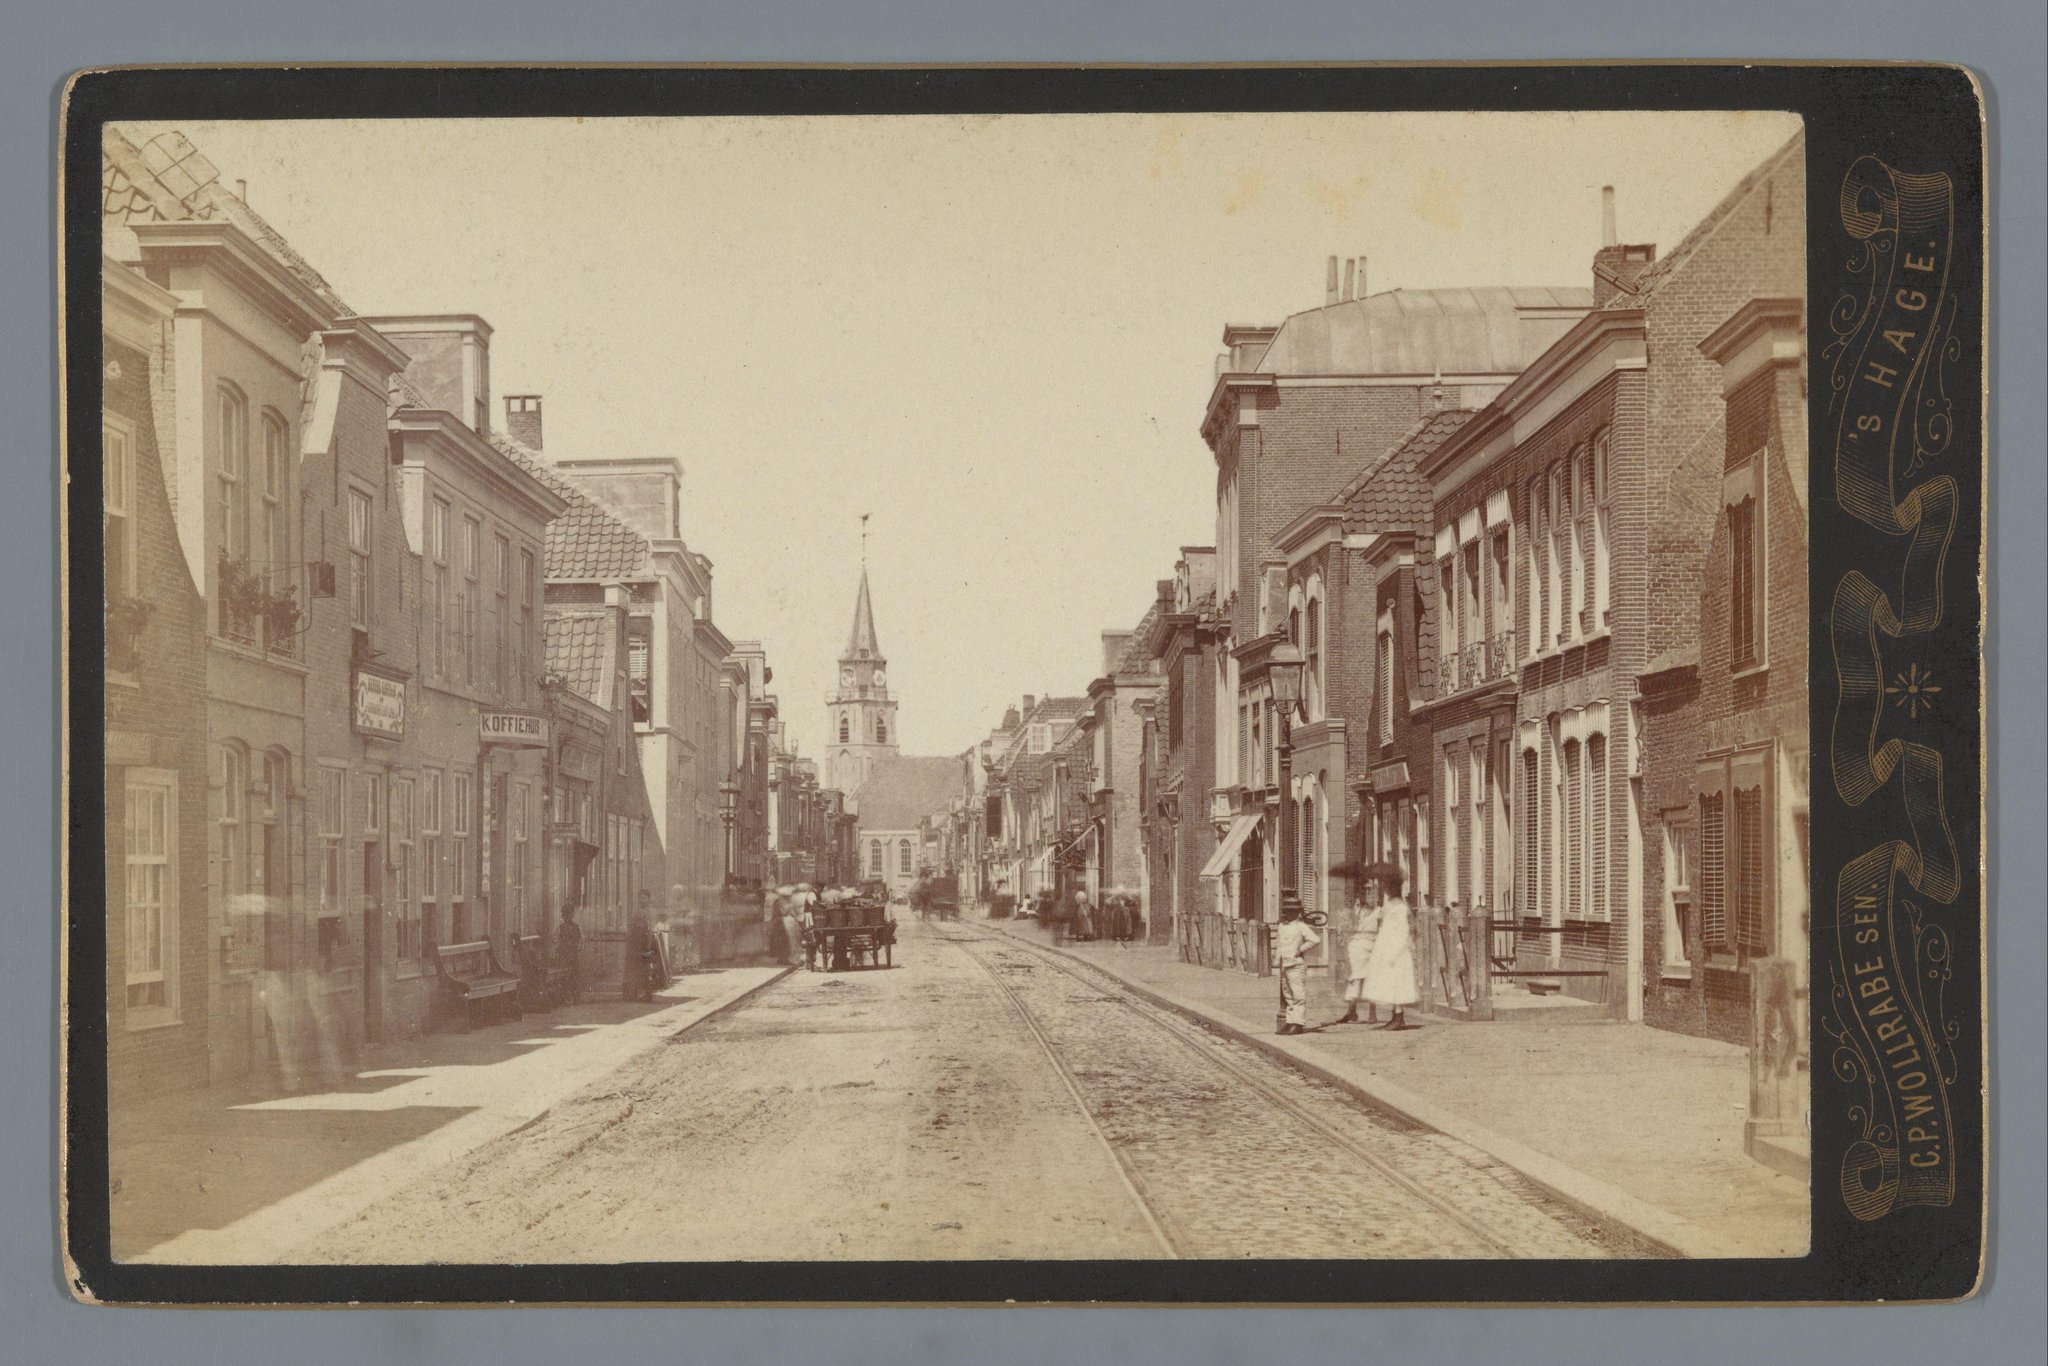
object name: photograph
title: Gezicht op de Keizerstraat te Scheveningen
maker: carl philip wollrabe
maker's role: fotograaf, musicus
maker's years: 1812-1887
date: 1885-1900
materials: cardboard, photographic support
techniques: albumen print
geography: keizerstraat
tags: church (exterior), façade (of house or building), street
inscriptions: inscription: ‘C.P. Wollrabe sen. (...) De plaat blijft tot nabestelling bewaard.’